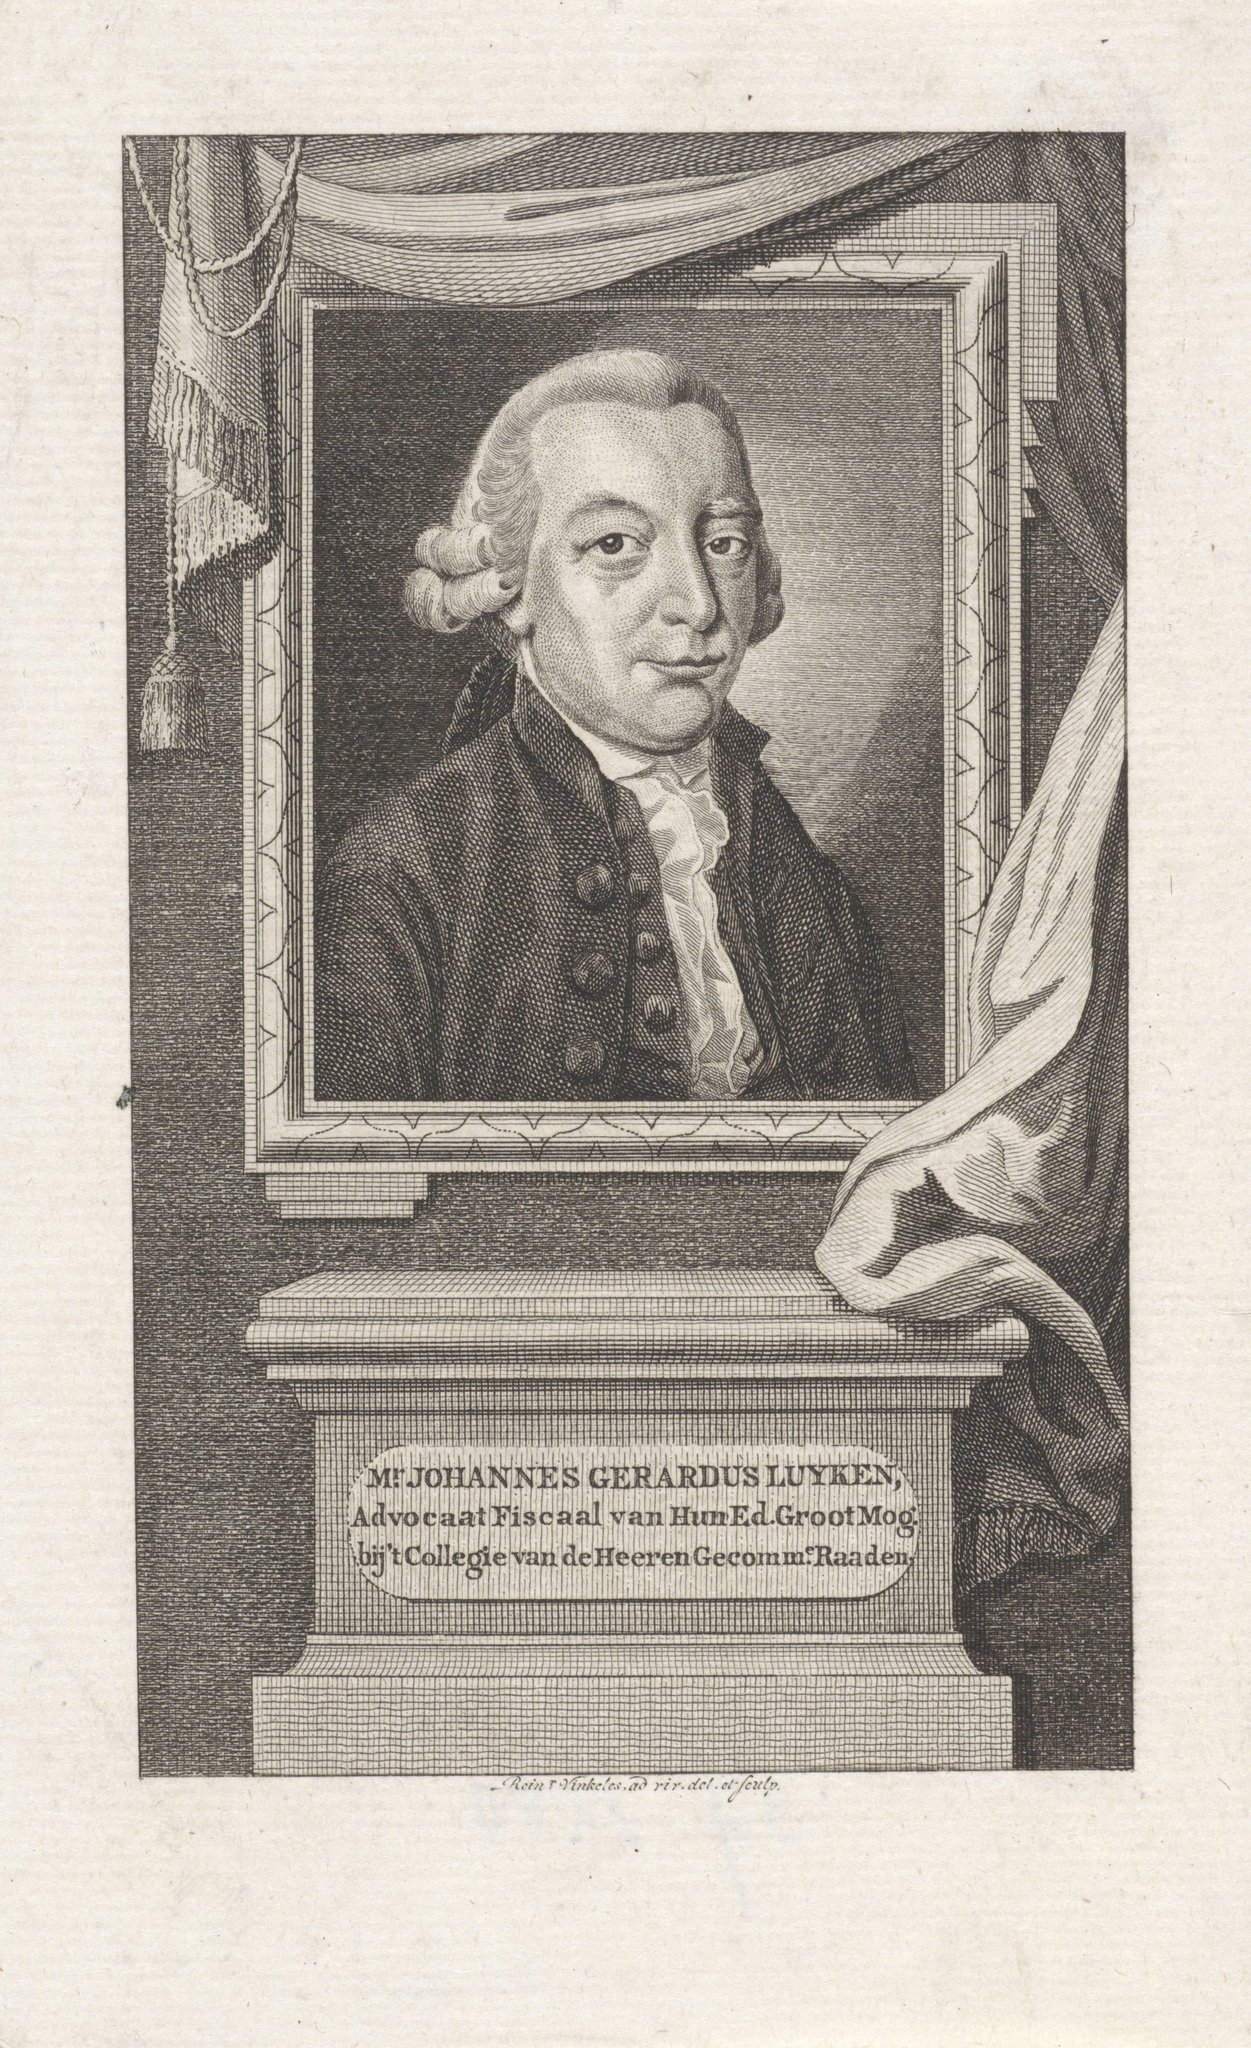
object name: print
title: Portret van de staatsman Johannes Gerardus Luyken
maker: reinier vinkeles (i)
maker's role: draughtsman, print maker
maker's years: 1741-1816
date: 1786-1809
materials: paper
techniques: etching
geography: amsterdam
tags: haarlem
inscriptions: collector's mark: Lugt 2228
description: Prent ook gebruikt als boekillustratie in: Wagenaar, Jan. Vaderlandsche historie, (...) ten vervolge van Wagenaars Vaderlandsche historie. Dl. 1-43. Amsterdam: Johannes Allart, 1786-1809.